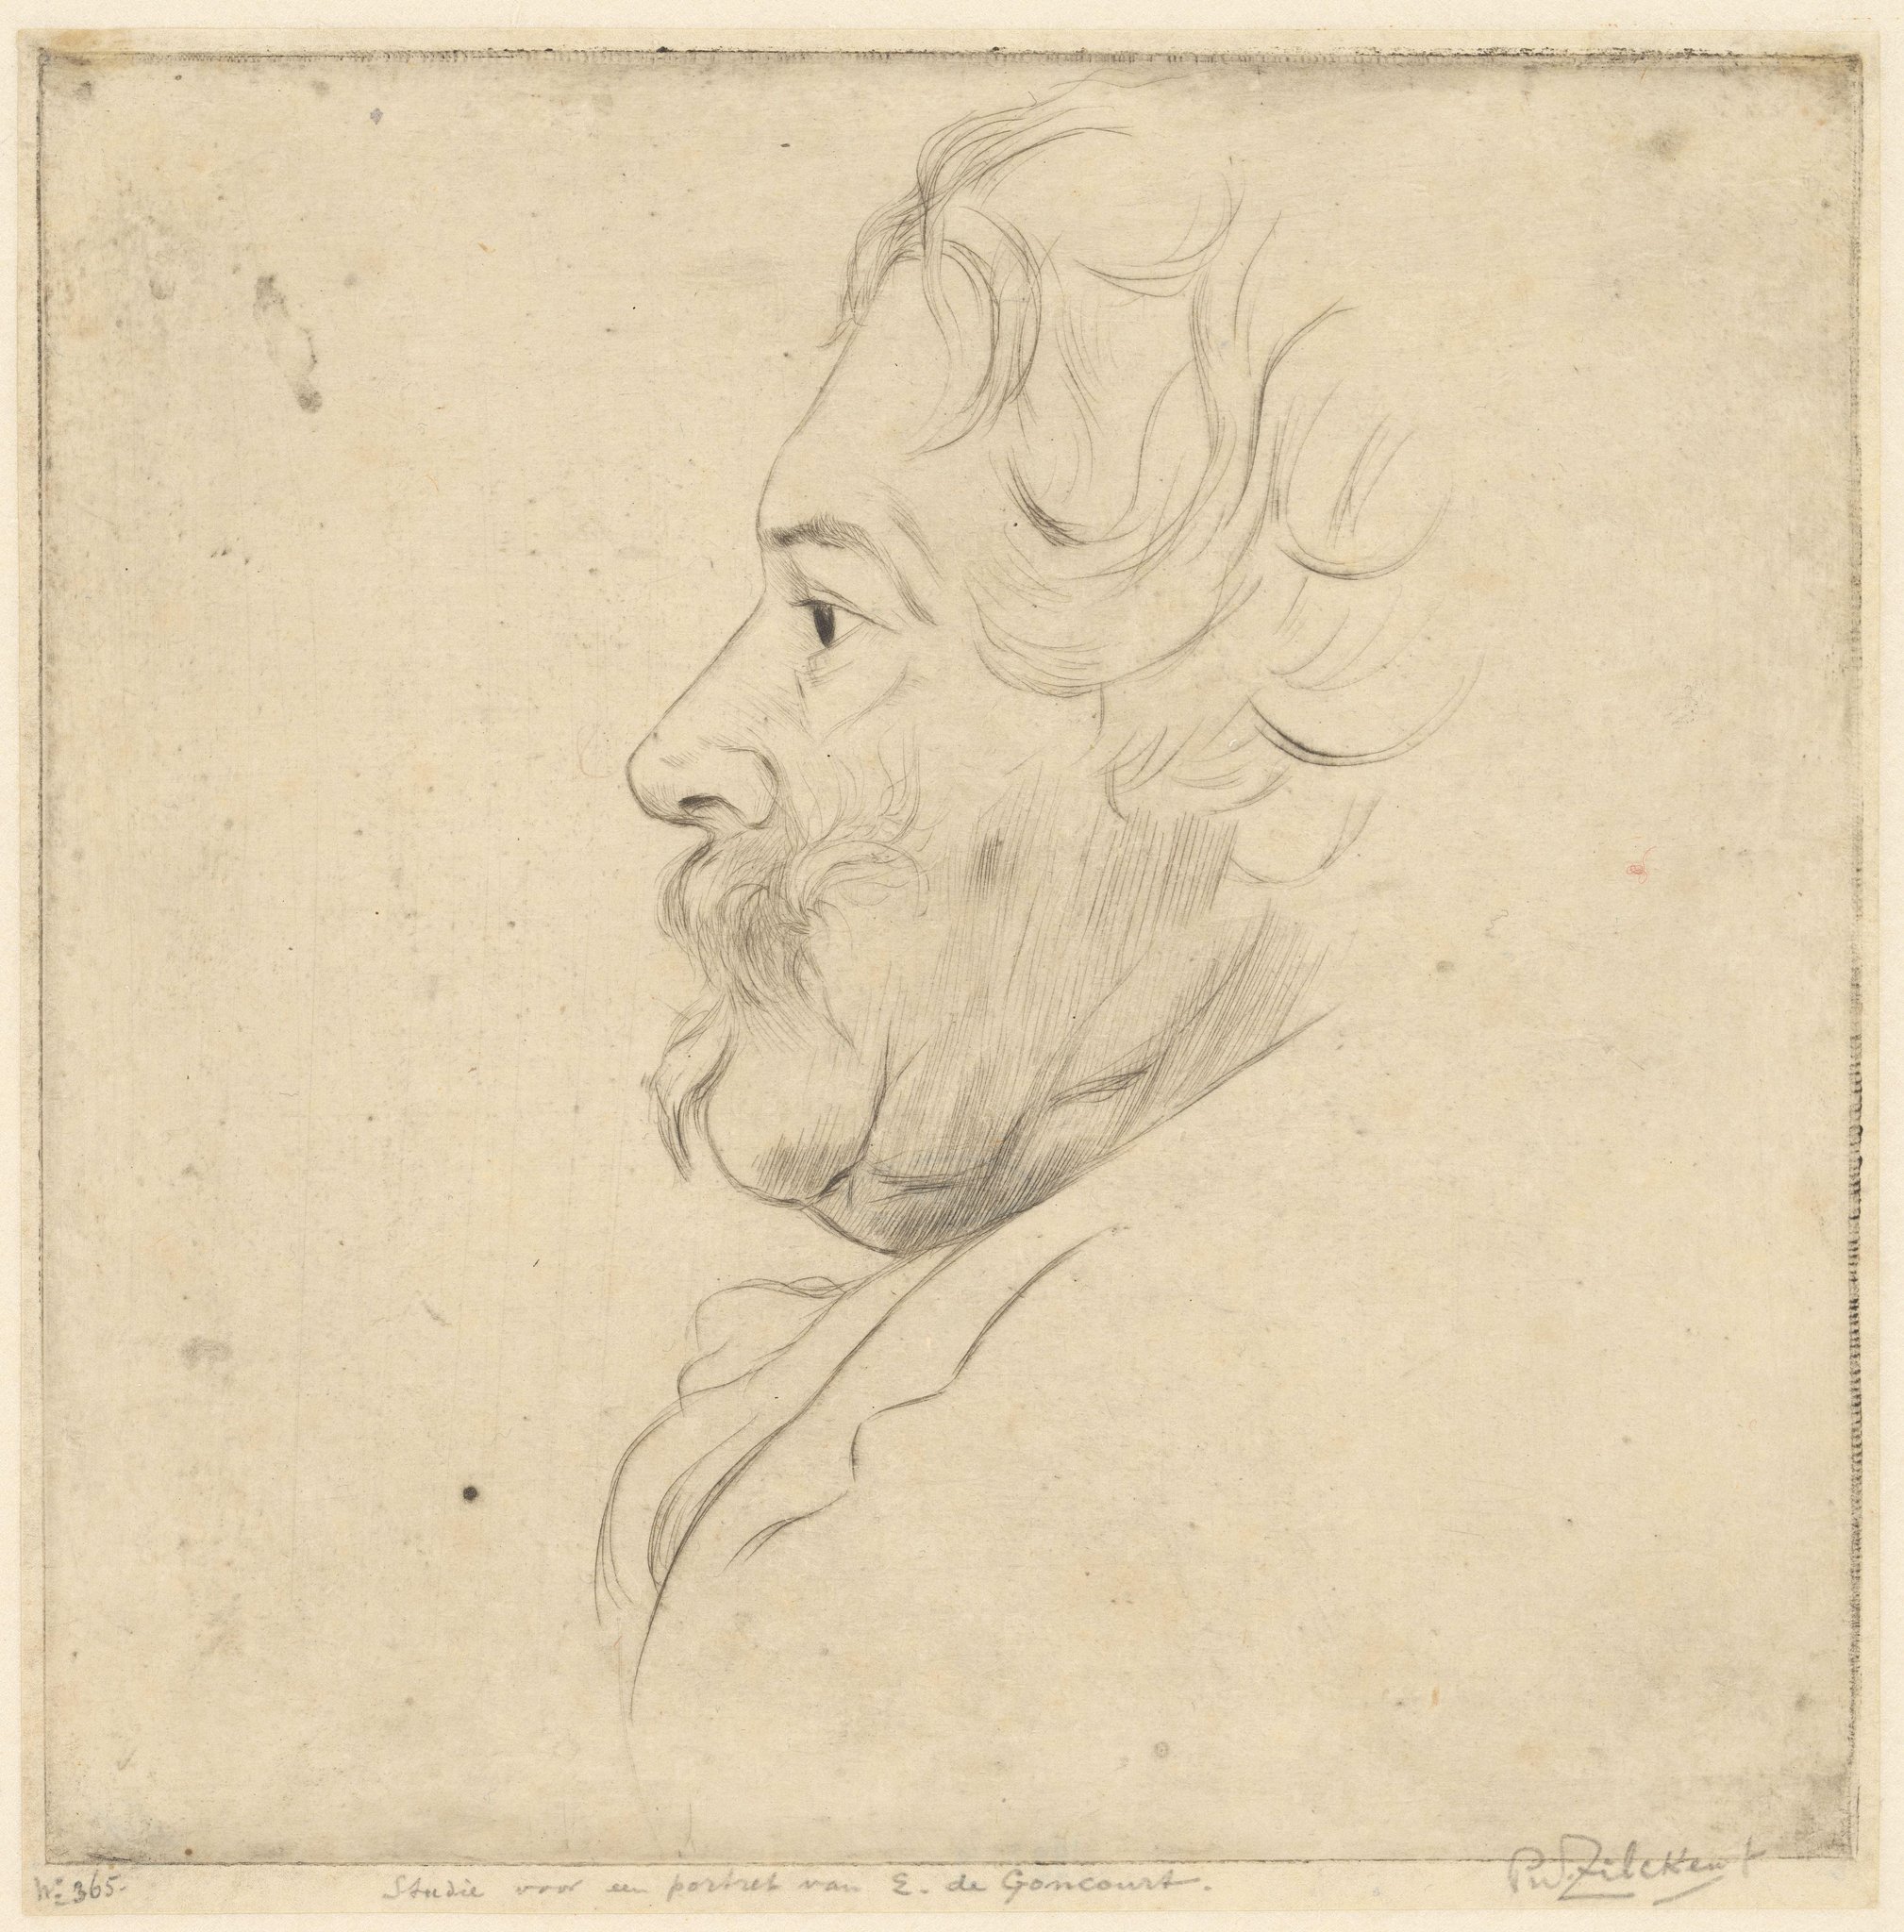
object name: print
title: Studie voor een portret van E. de Goncourt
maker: philip zilcken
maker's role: draughtsman, painter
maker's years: 1857-1930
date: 1890-1896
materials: paper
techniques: drypoint, intaglio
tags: painter, draughtsman, edmond de goncourt, historical persons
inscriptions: collector's mark: Lugt 2228, collector's mark: Lugt 2760